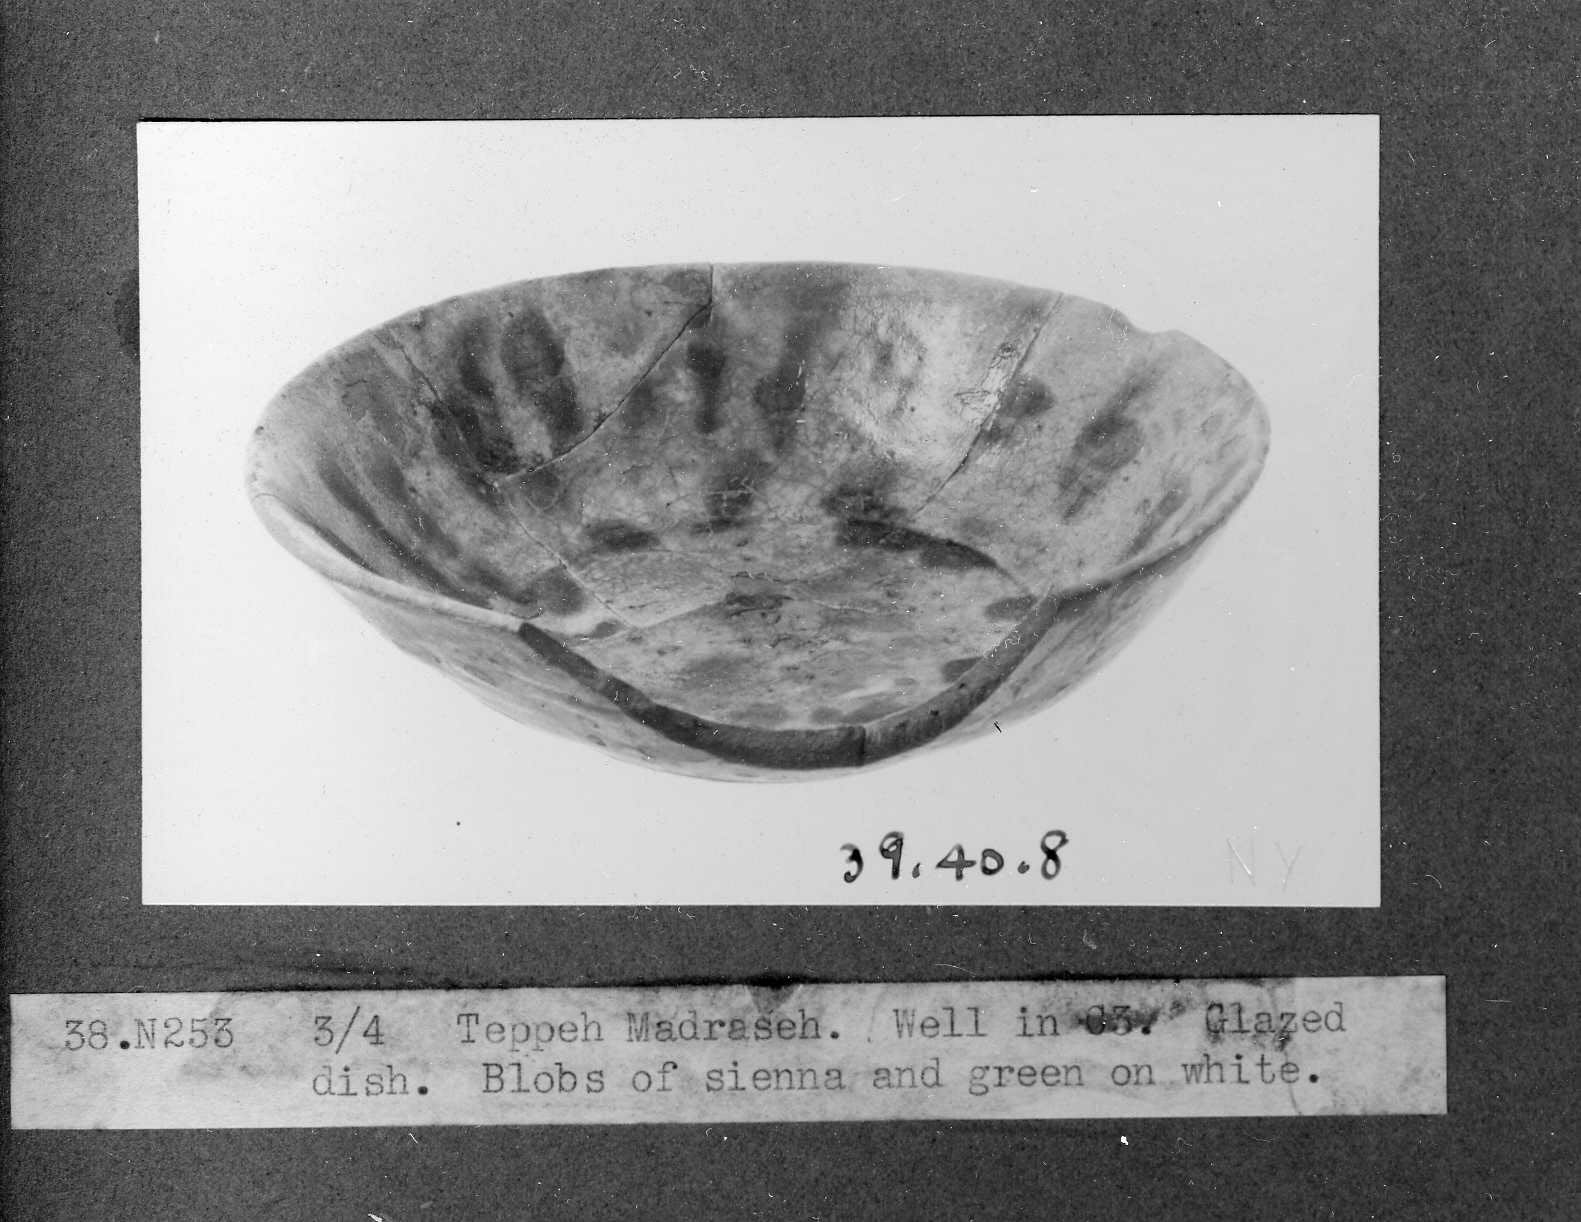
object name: dish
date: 801-1000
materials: earthenware, glaze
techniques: polychrome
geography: iran